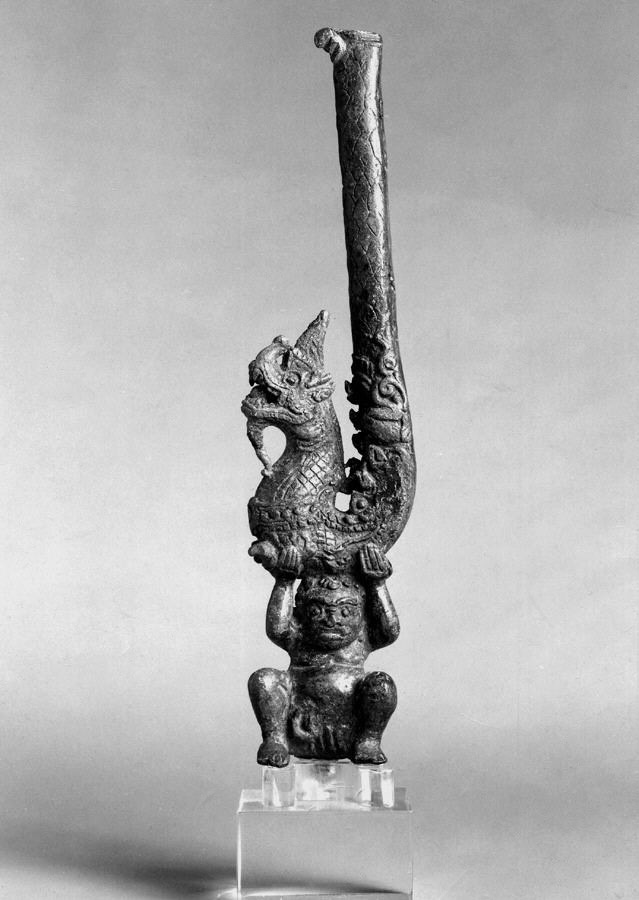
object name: figure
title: Yaksha Supporting a Naga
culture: thai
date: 1101-1200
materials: bronze, gilt